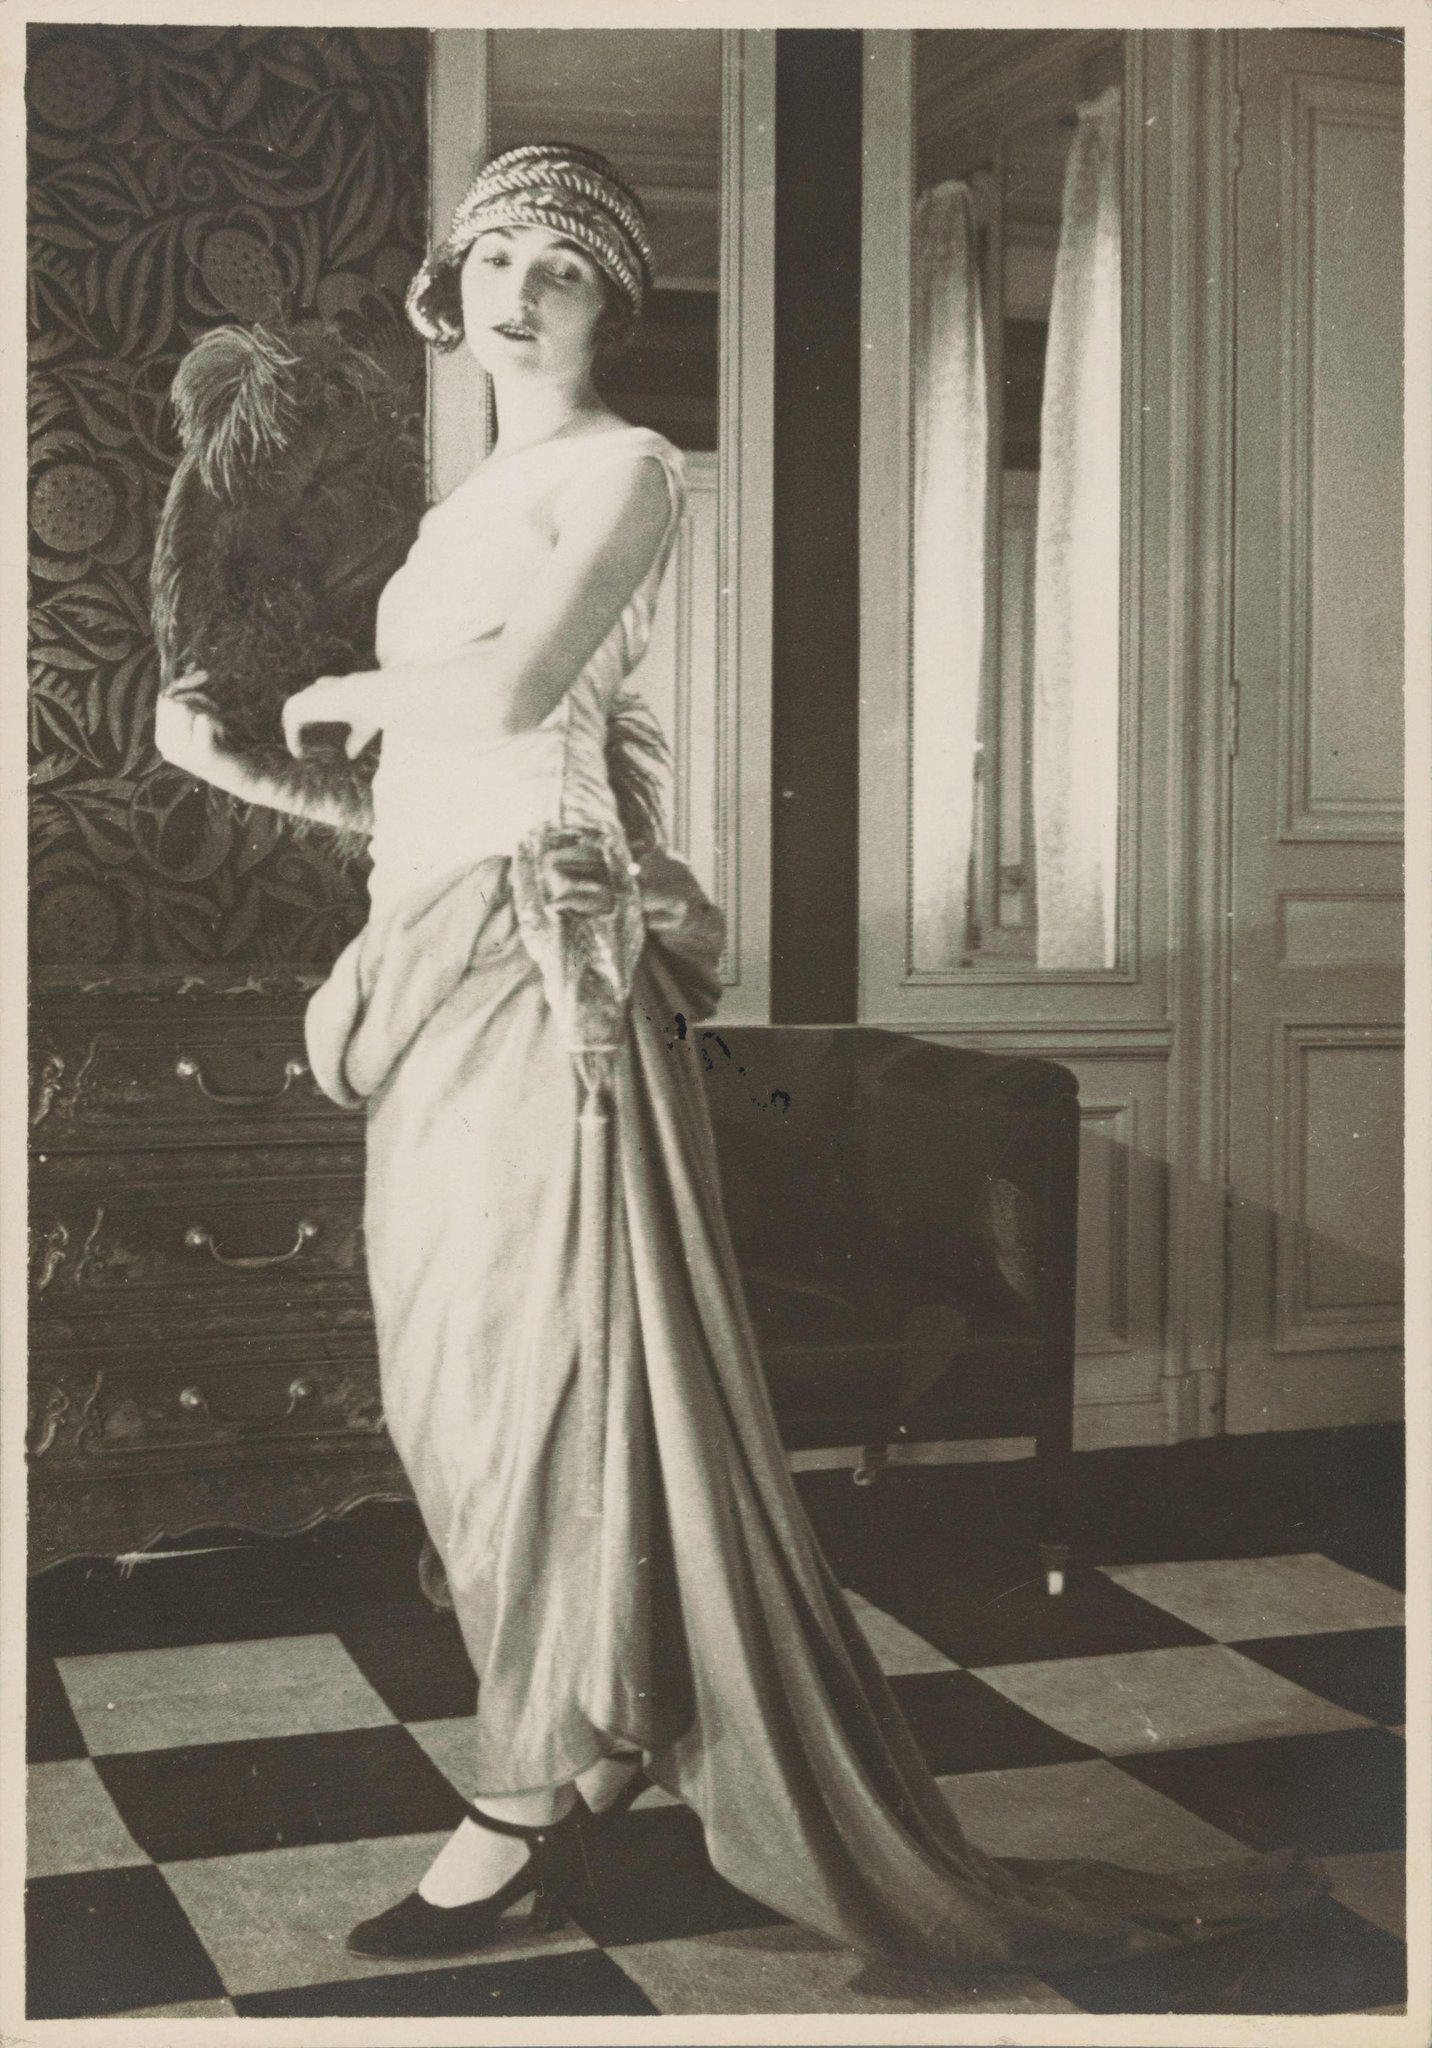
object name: photograph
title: Modefoto van een vrouw in een jurk van Paul Poiret, Parijs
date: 1923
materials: paper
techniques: gelatin silver print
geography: paris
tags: paul poiret, model, mannequin, paris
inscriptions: inscription: ‘(stempel) P.Pon DE PAUL POIRET, (stempel) PAUL POIRET / 3 MARS 1923 / [...], (potlood en pen): 3502 Milo [?], [...]’